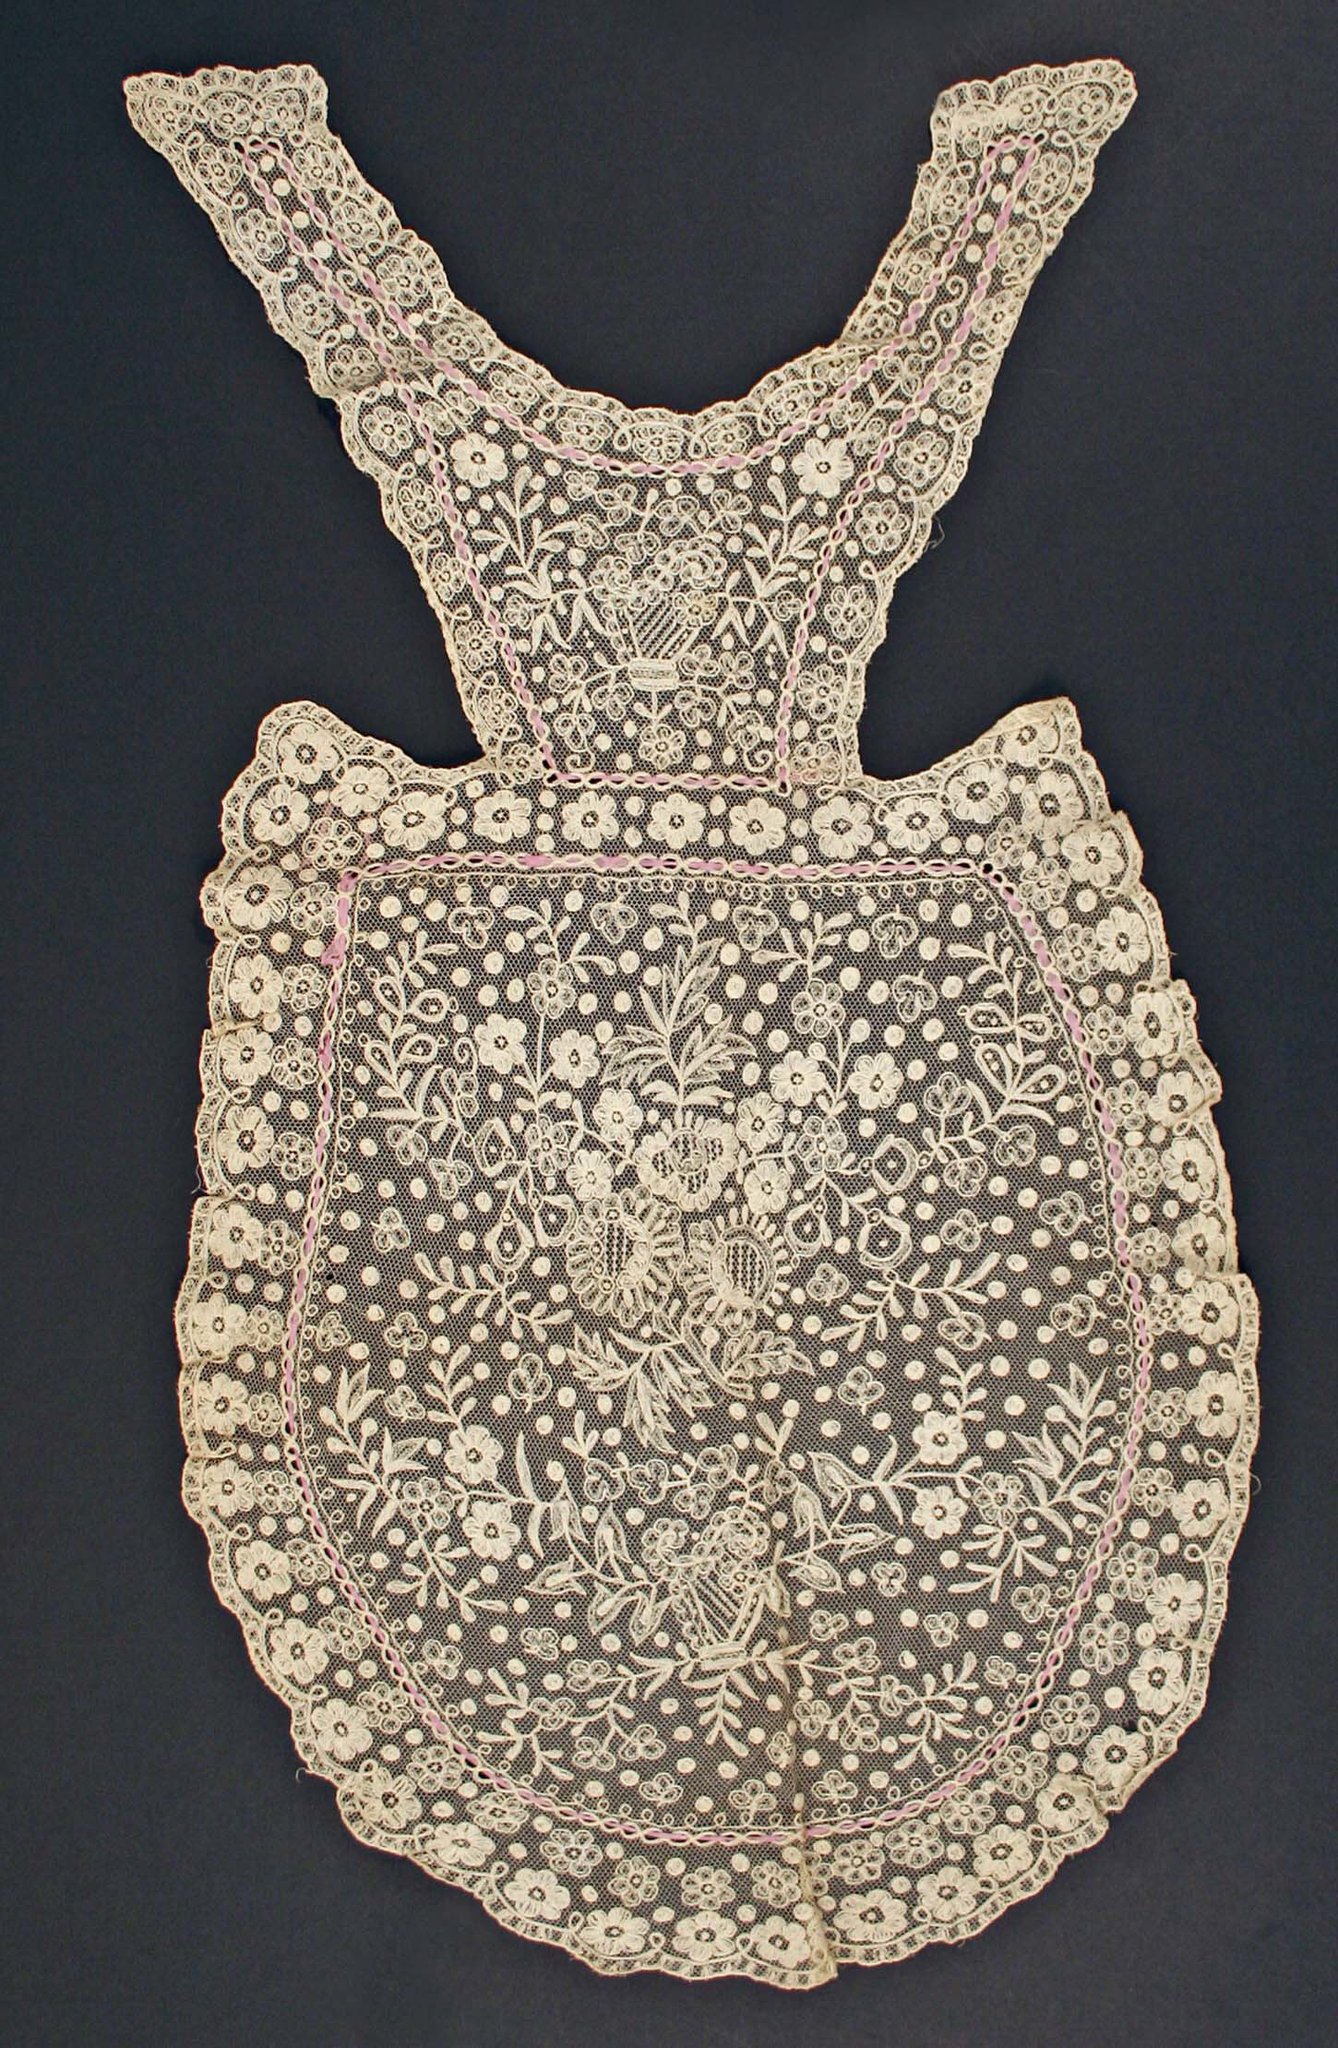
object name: pinafore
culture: irish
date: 1884